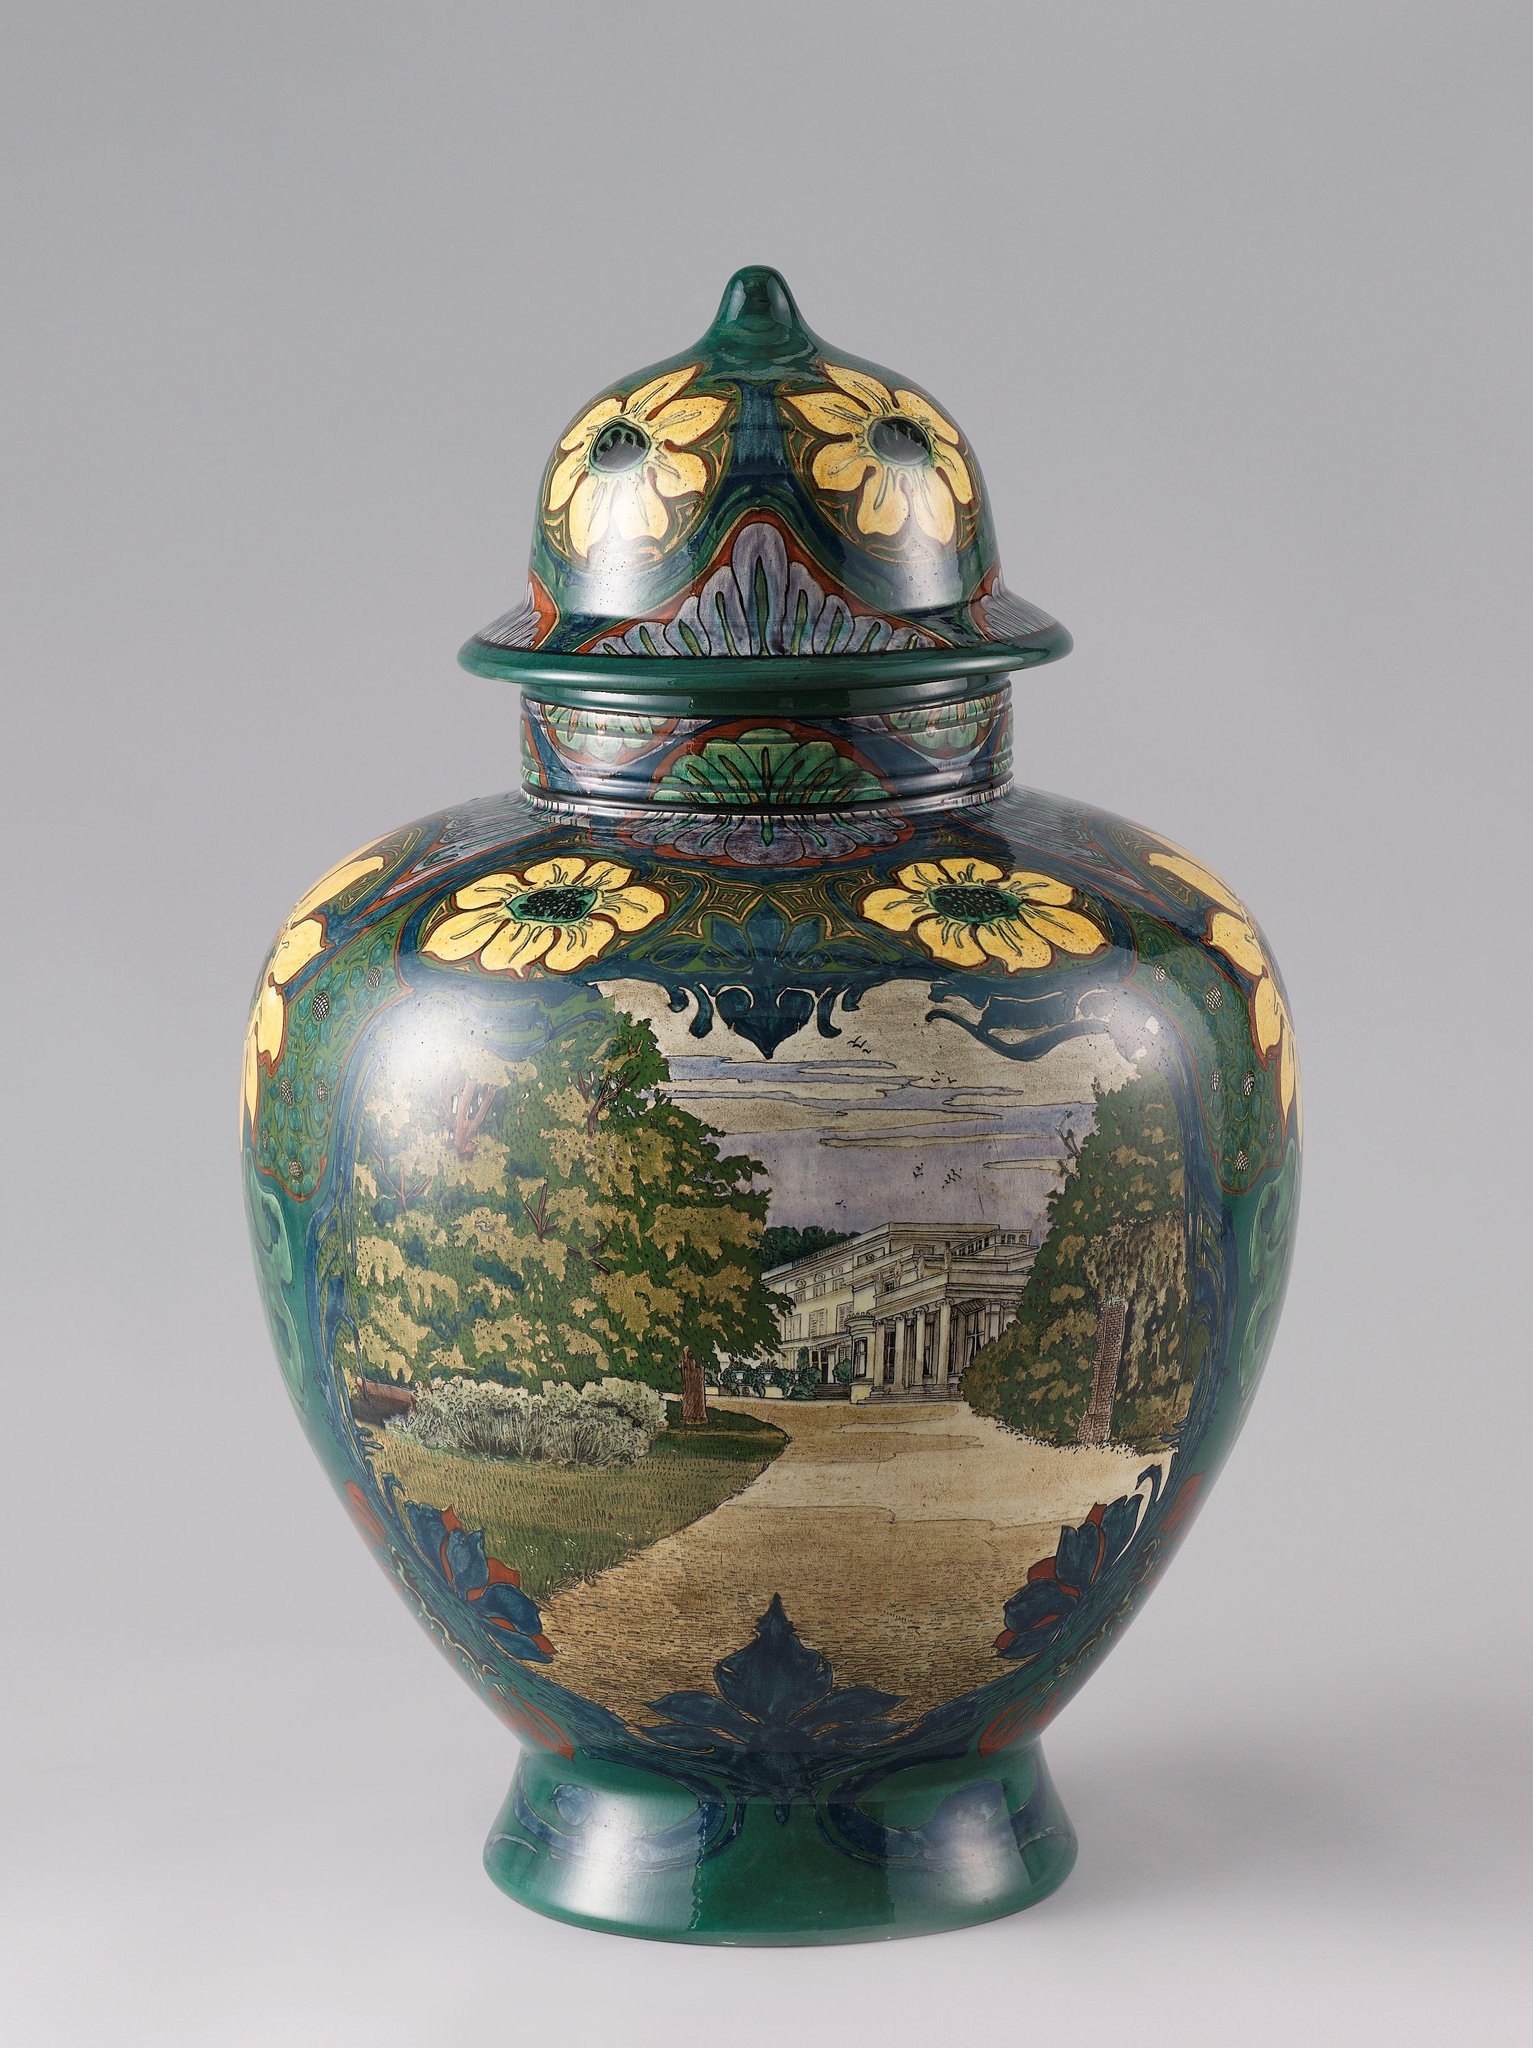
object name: lid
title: Deksel van vaas met het huis De Paauw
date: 1896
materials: earthenware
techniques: painted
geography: the hague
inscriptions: mark: ‘Rozenburg // ooievaar // Den Haag ; NK (aaneen) x 473 ; LW110 (ingegrift)’, mark: ‘Rozenburg // ooievaar // Den Haag ; NK (aaneen) x 473 ; LW110 (ingegrift)’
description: Deksel van vaas van aardewerk, behorend bij een stel van drie, polychroom beschilderd met zonnebloemen en topografische voorstellingen. Op de deksel zijn vier zonnebloemen geschilderd.